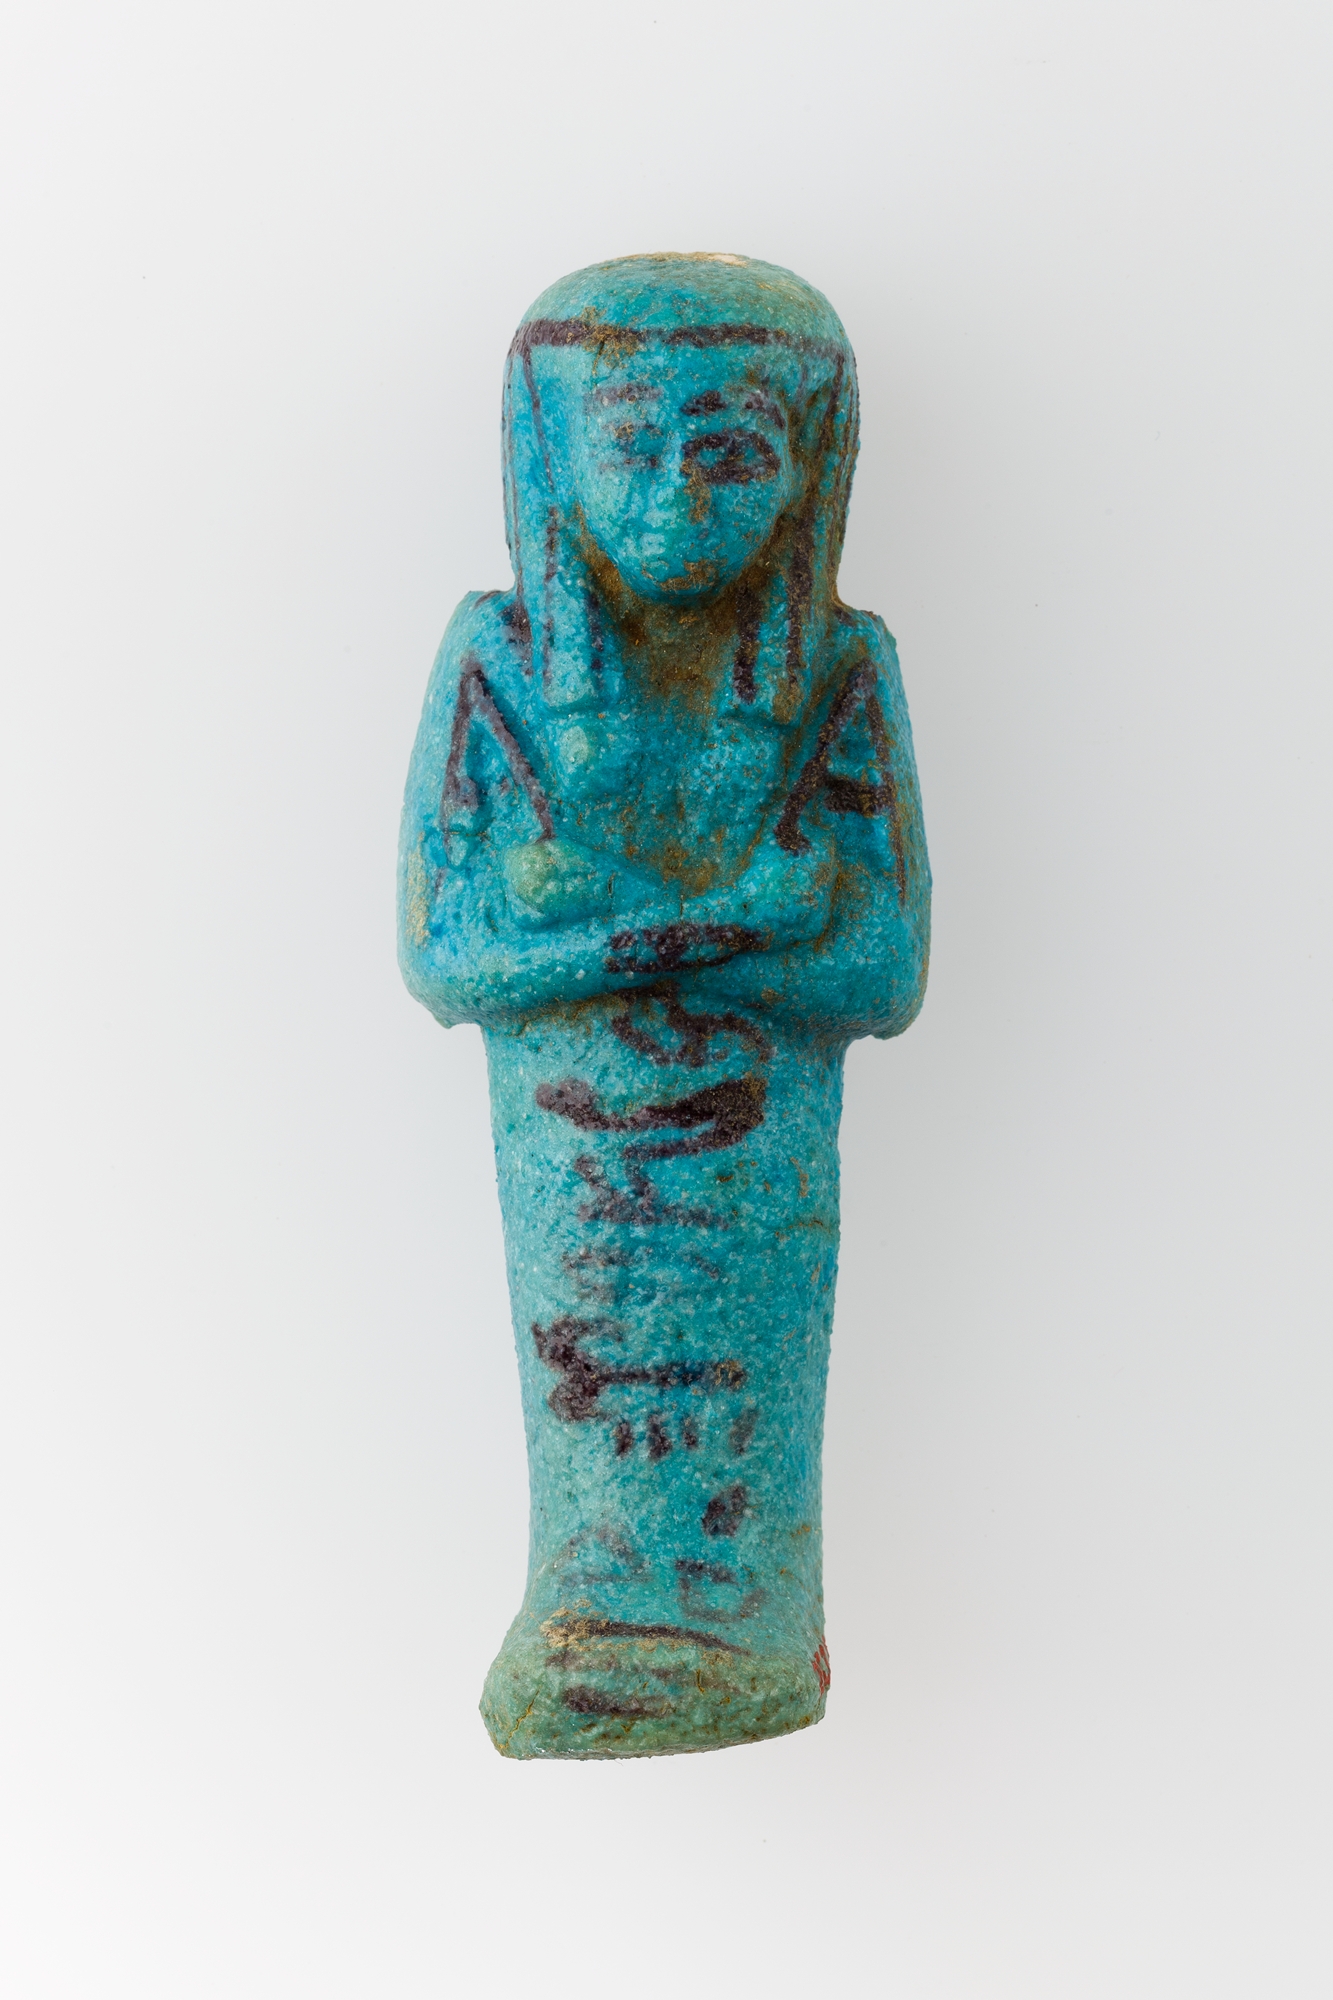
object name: shabti, henettawy c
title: Worker Shabti of Henettawy (C), Daughter of Isetemkheb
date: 990-970 BCE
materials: faience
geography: egypt